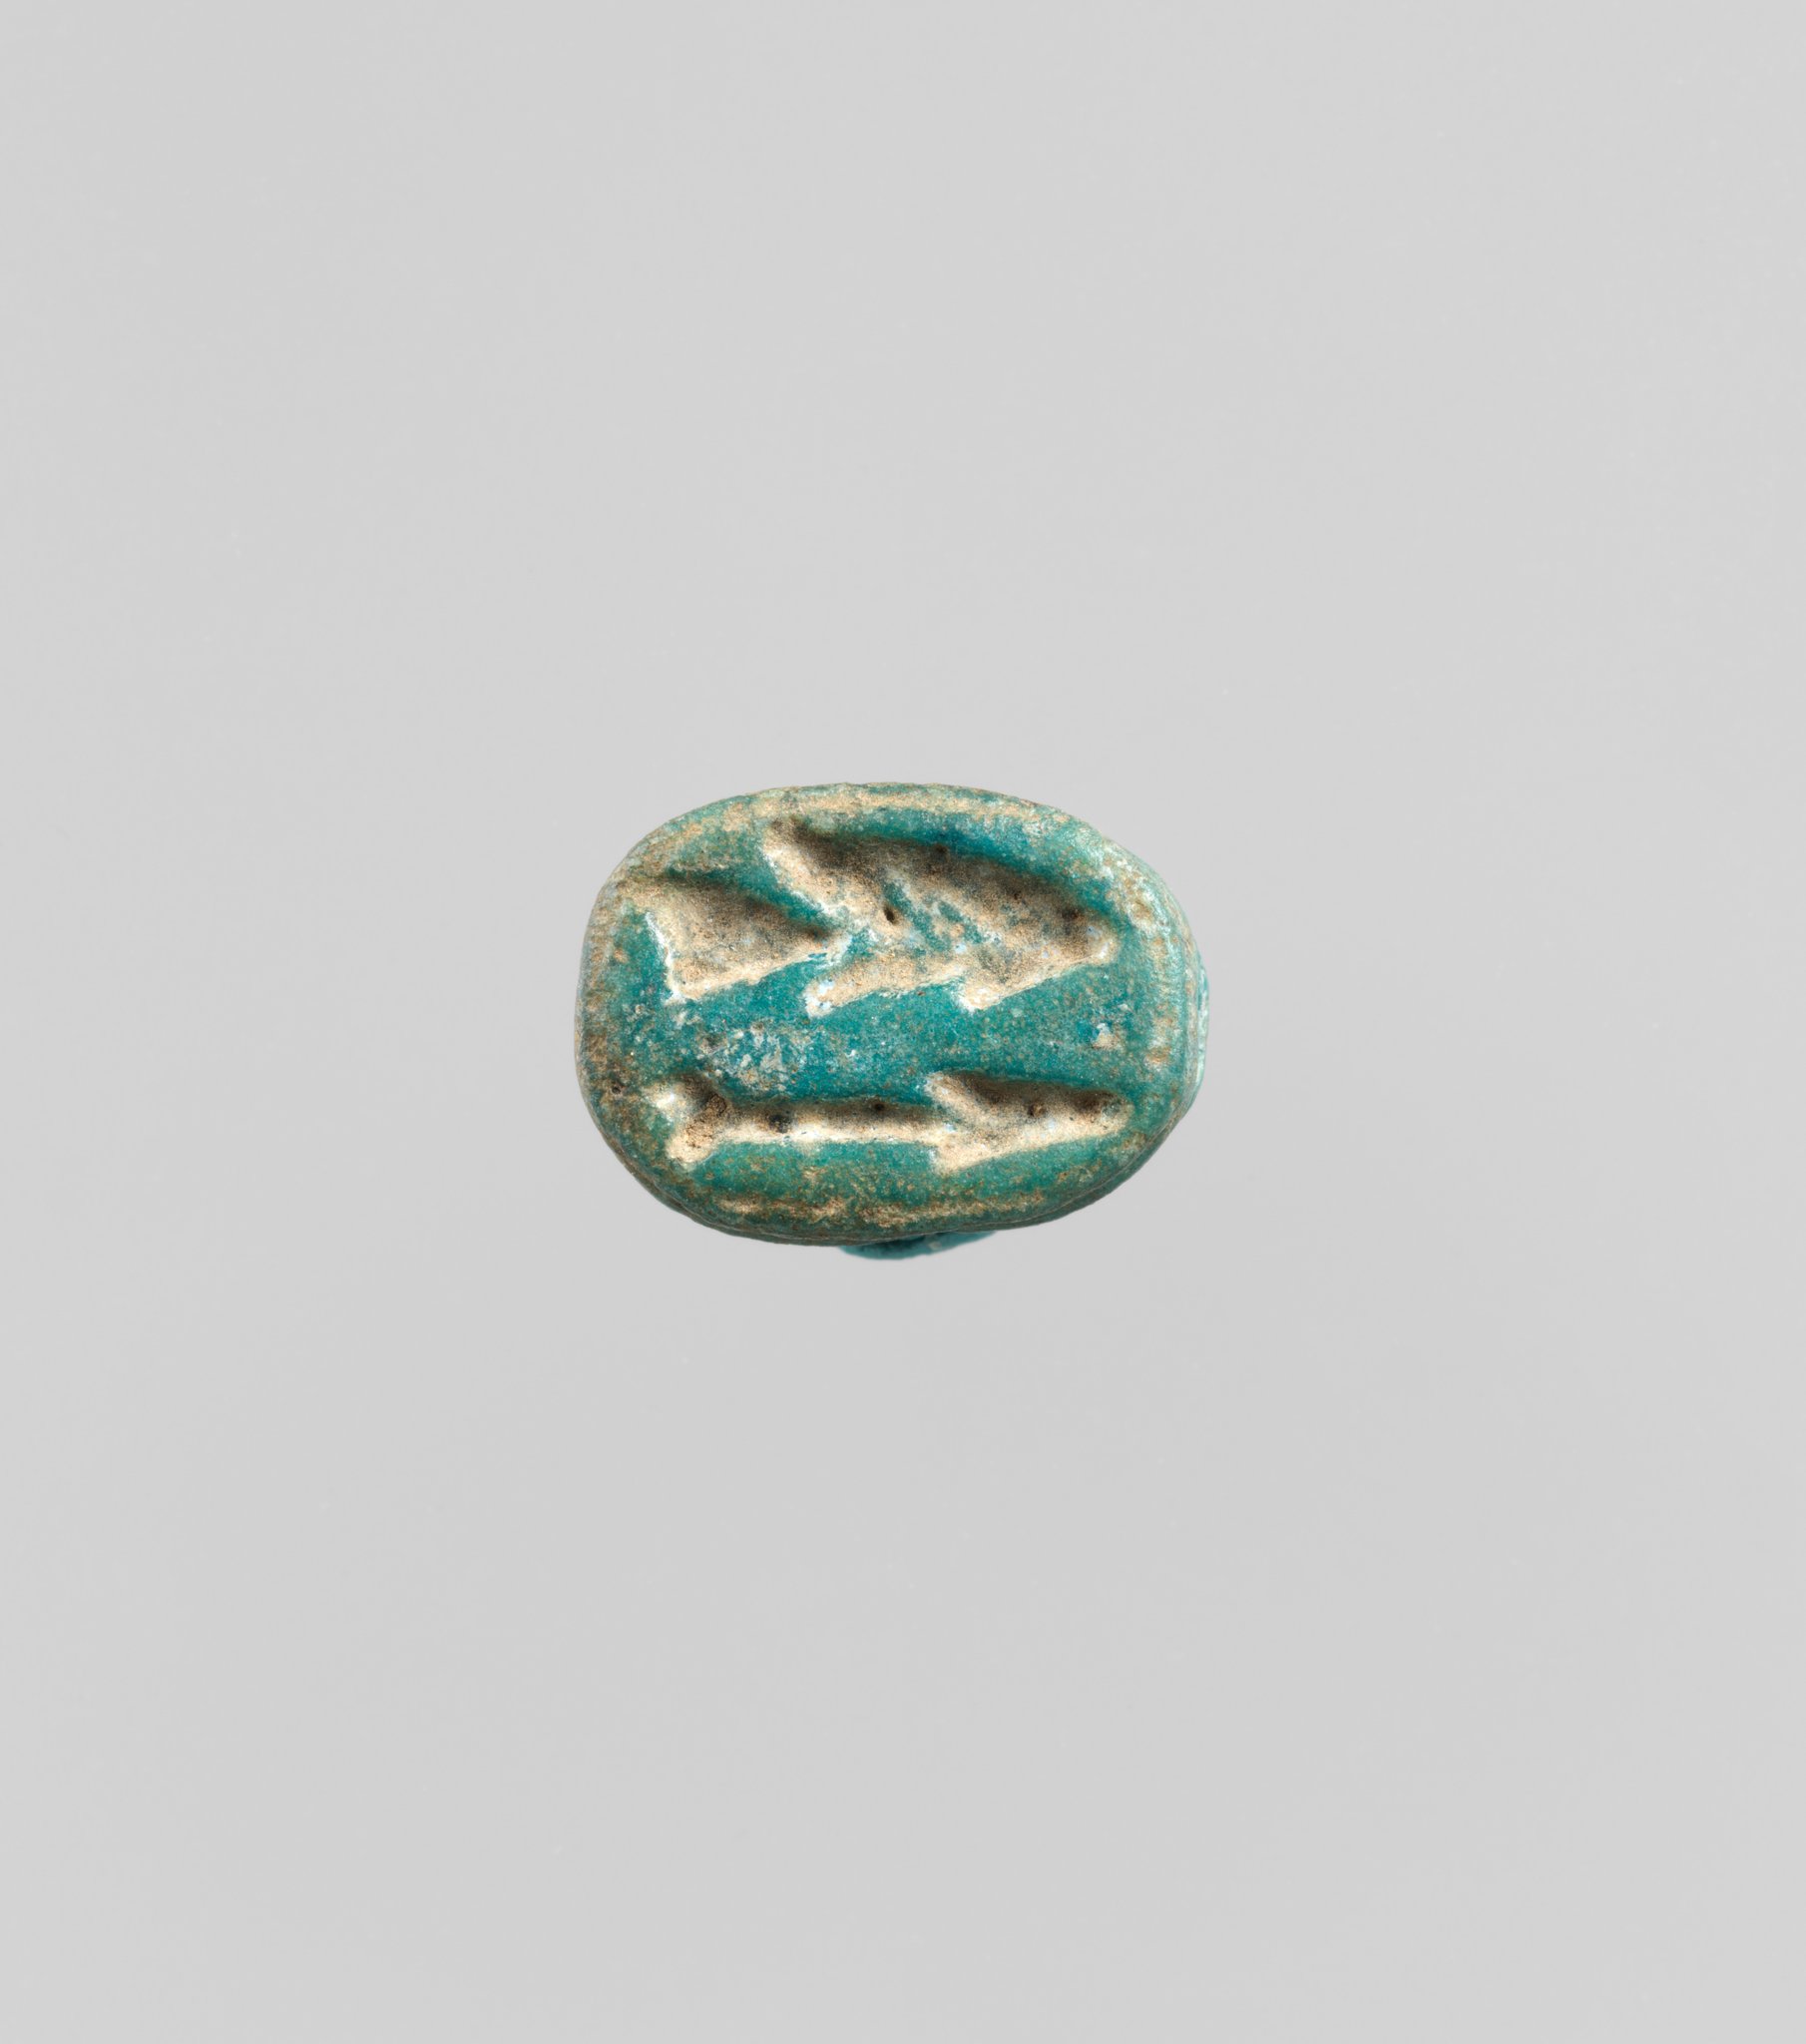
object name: scarab, fish, hieroglyph, harpoon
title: Scarab with the Representation of a Fish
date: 1479-1070 BCE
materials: faience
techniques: glazing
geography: egypt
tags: fish